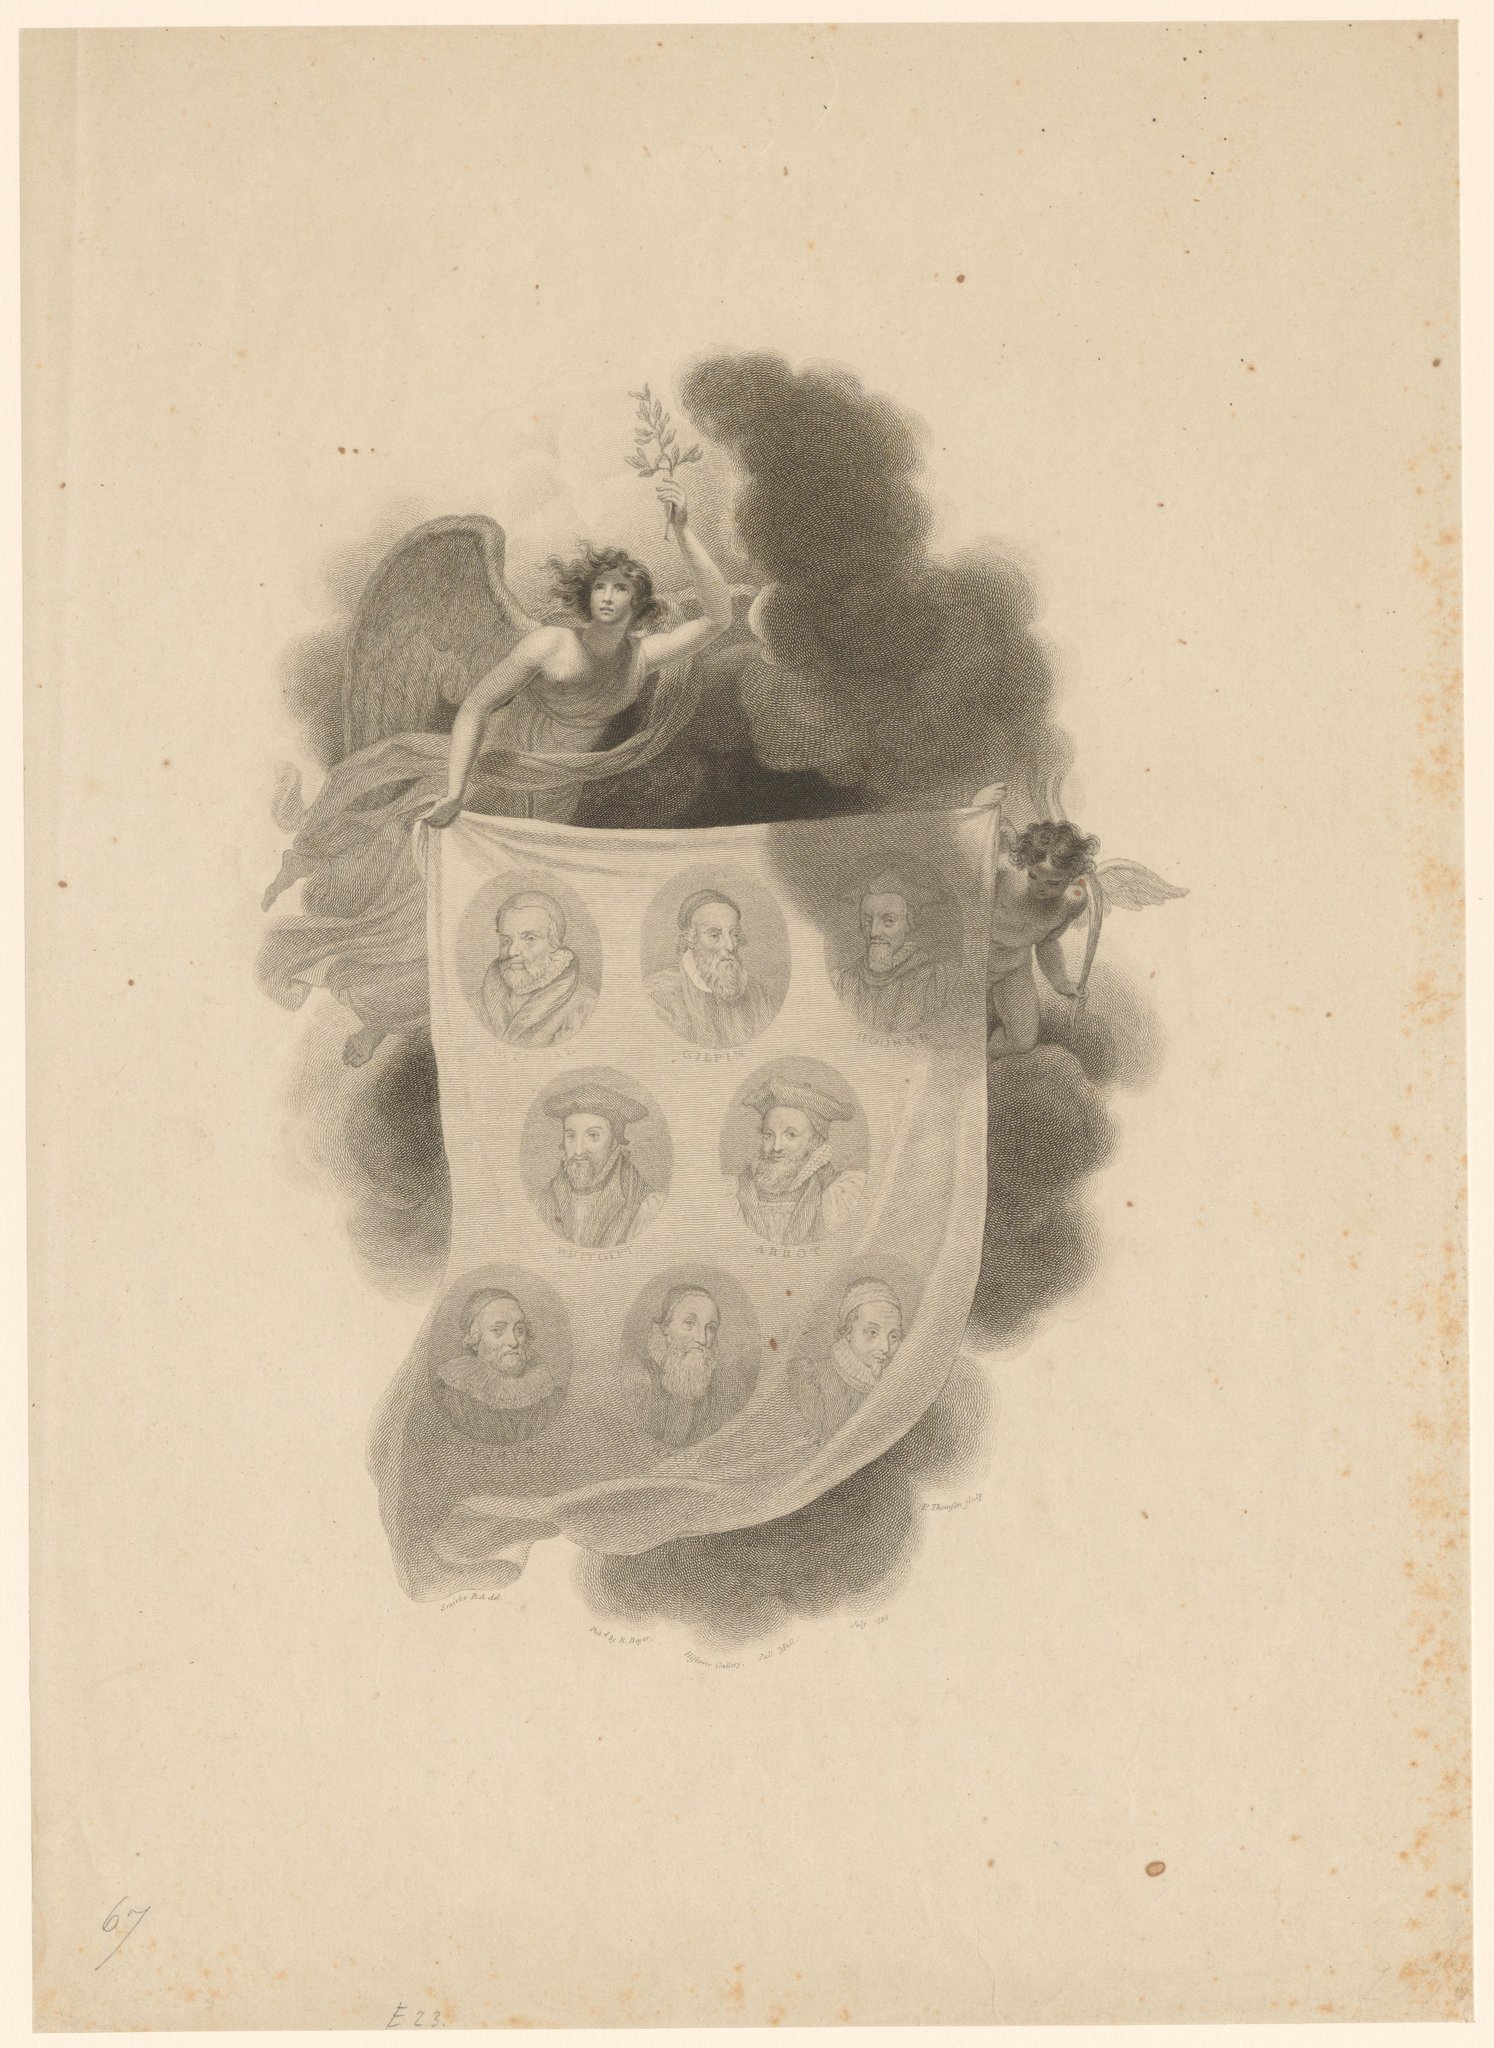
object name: print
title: Schilderijen en tekeningen bij Hume's History of England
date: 1707-1795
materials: paper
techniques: etching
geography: london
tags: priest, archbishop, bishop, etc. (roman catholic), historical persons, cupids: 'amores', 'amoretti', 'putti', angels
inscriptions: collector's mark: Lugt 2228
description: De prenten uit deze serie zijn naar schilderijen en tekeningen uit Bowyer's Historic Gallery. Deze schilderijen en tekeningen illustreerden de gebeurtenissen uit David Hume's History of England. De prenten zijn daarom mogelijk gebruikt als illustratie in deze boeken.